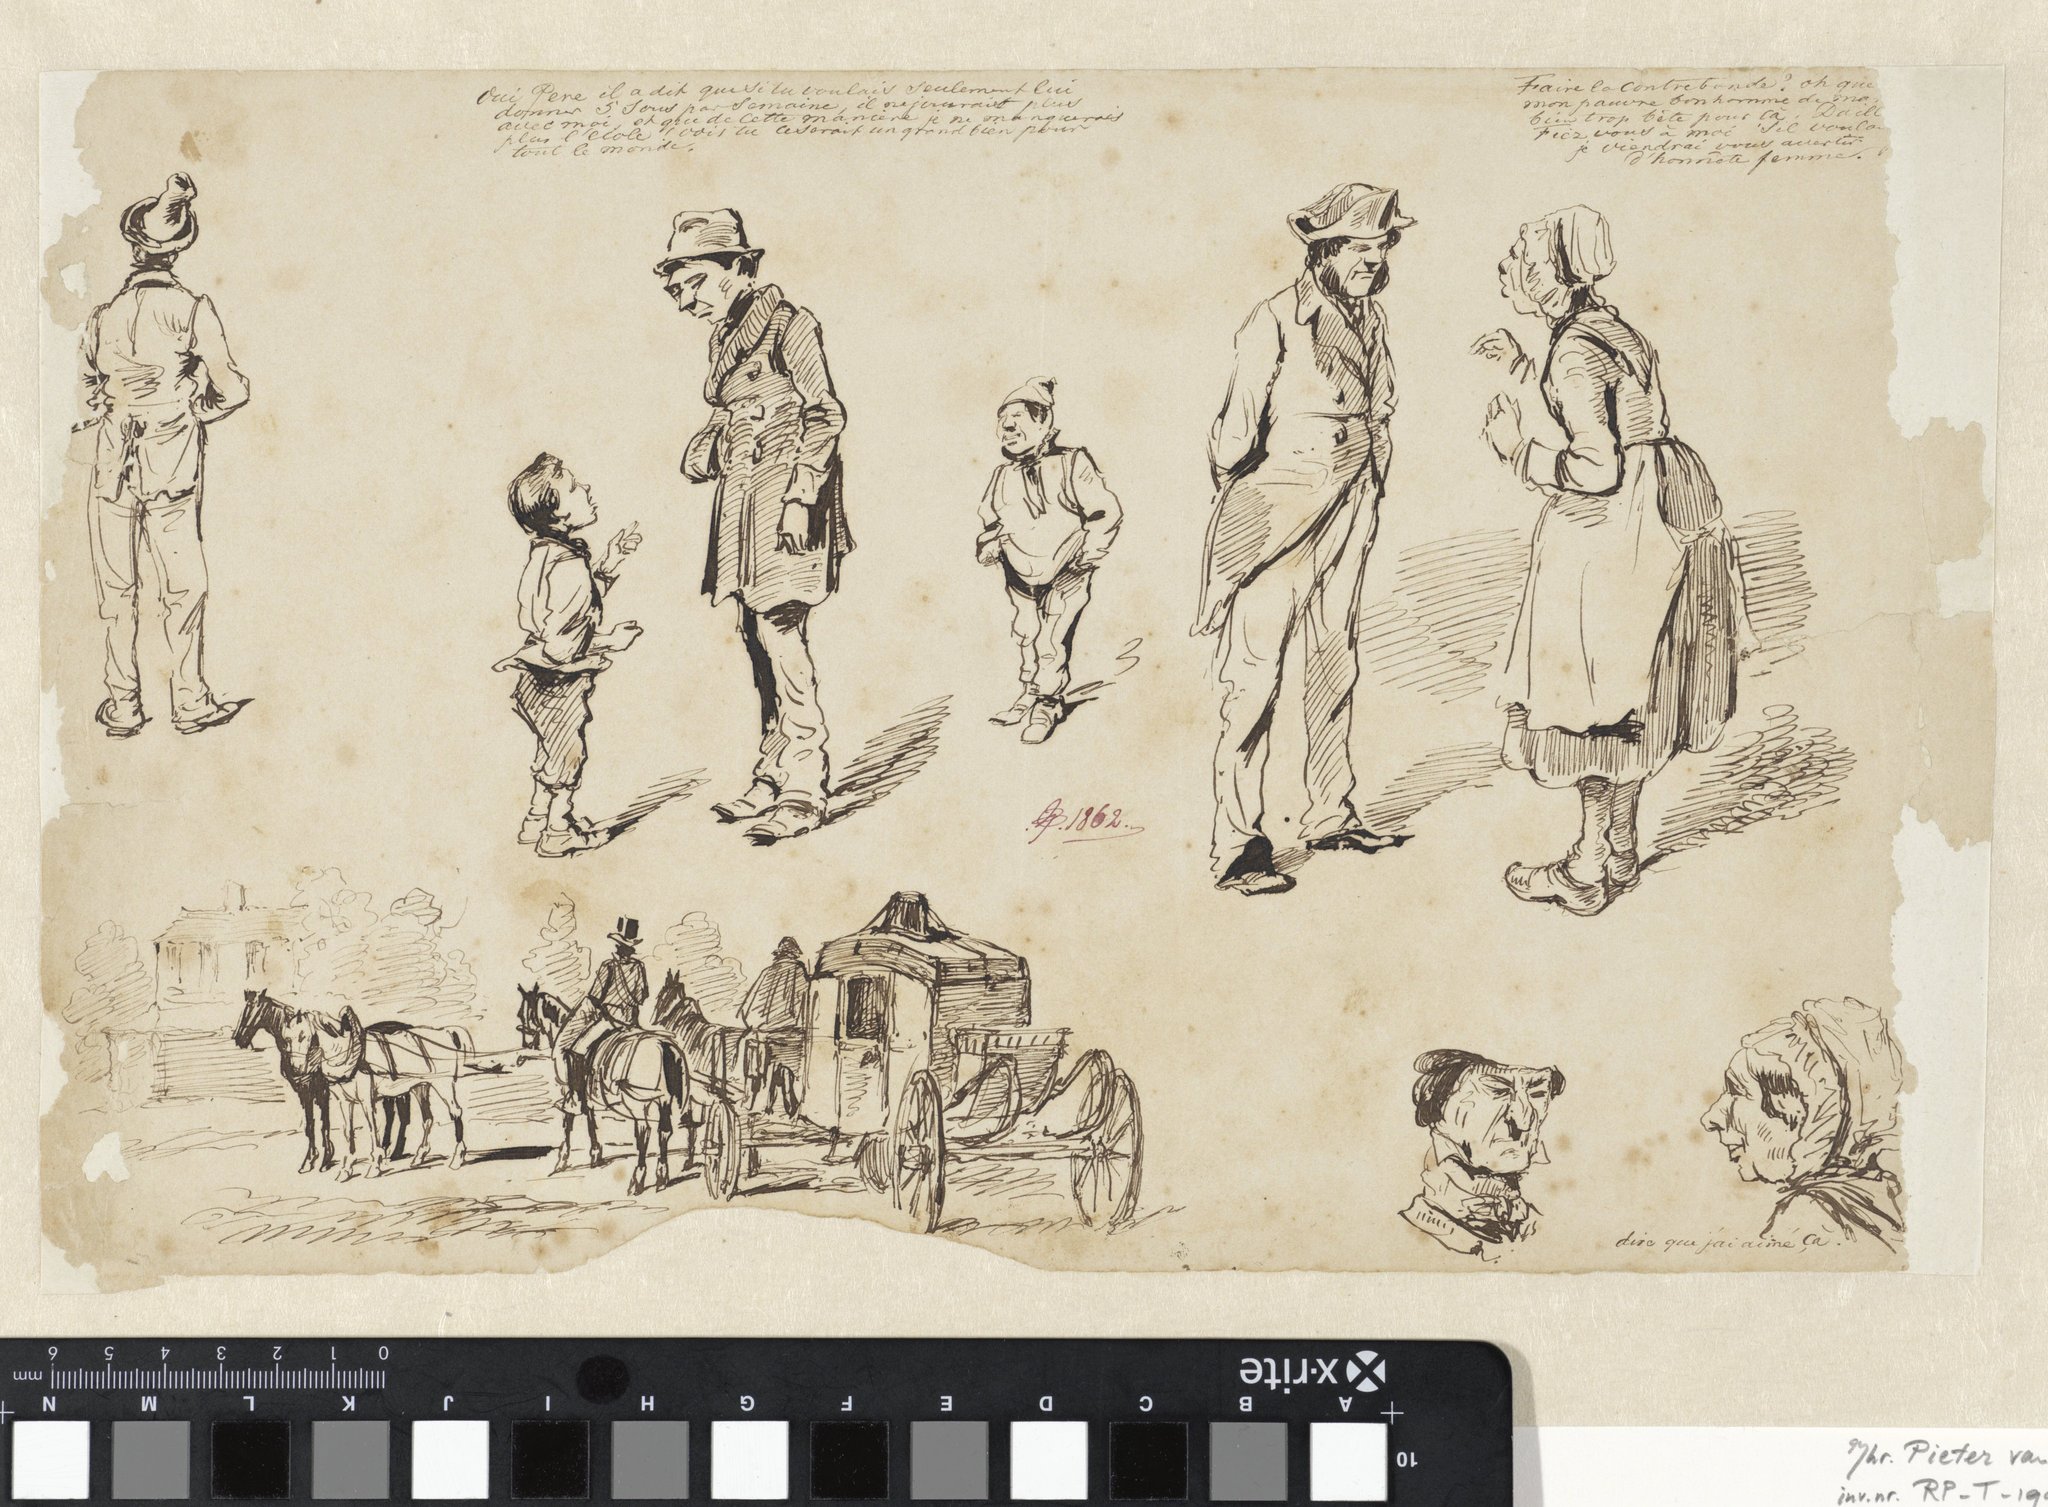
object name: drawing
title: Karikaturale figuren en een koets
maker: pieter van loon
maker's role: draughtsman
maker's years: 1801-1873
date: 1862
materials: ink, paper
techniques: pen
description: Karikaturale figuren, deels in dialogen, en een koets. Met drie bijschriften, waaronder rechtsonder: dire que j'ai aimé ça.